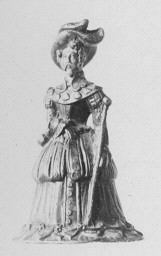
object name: costume bell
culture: french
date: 1801-1900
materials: metal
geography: france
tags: women